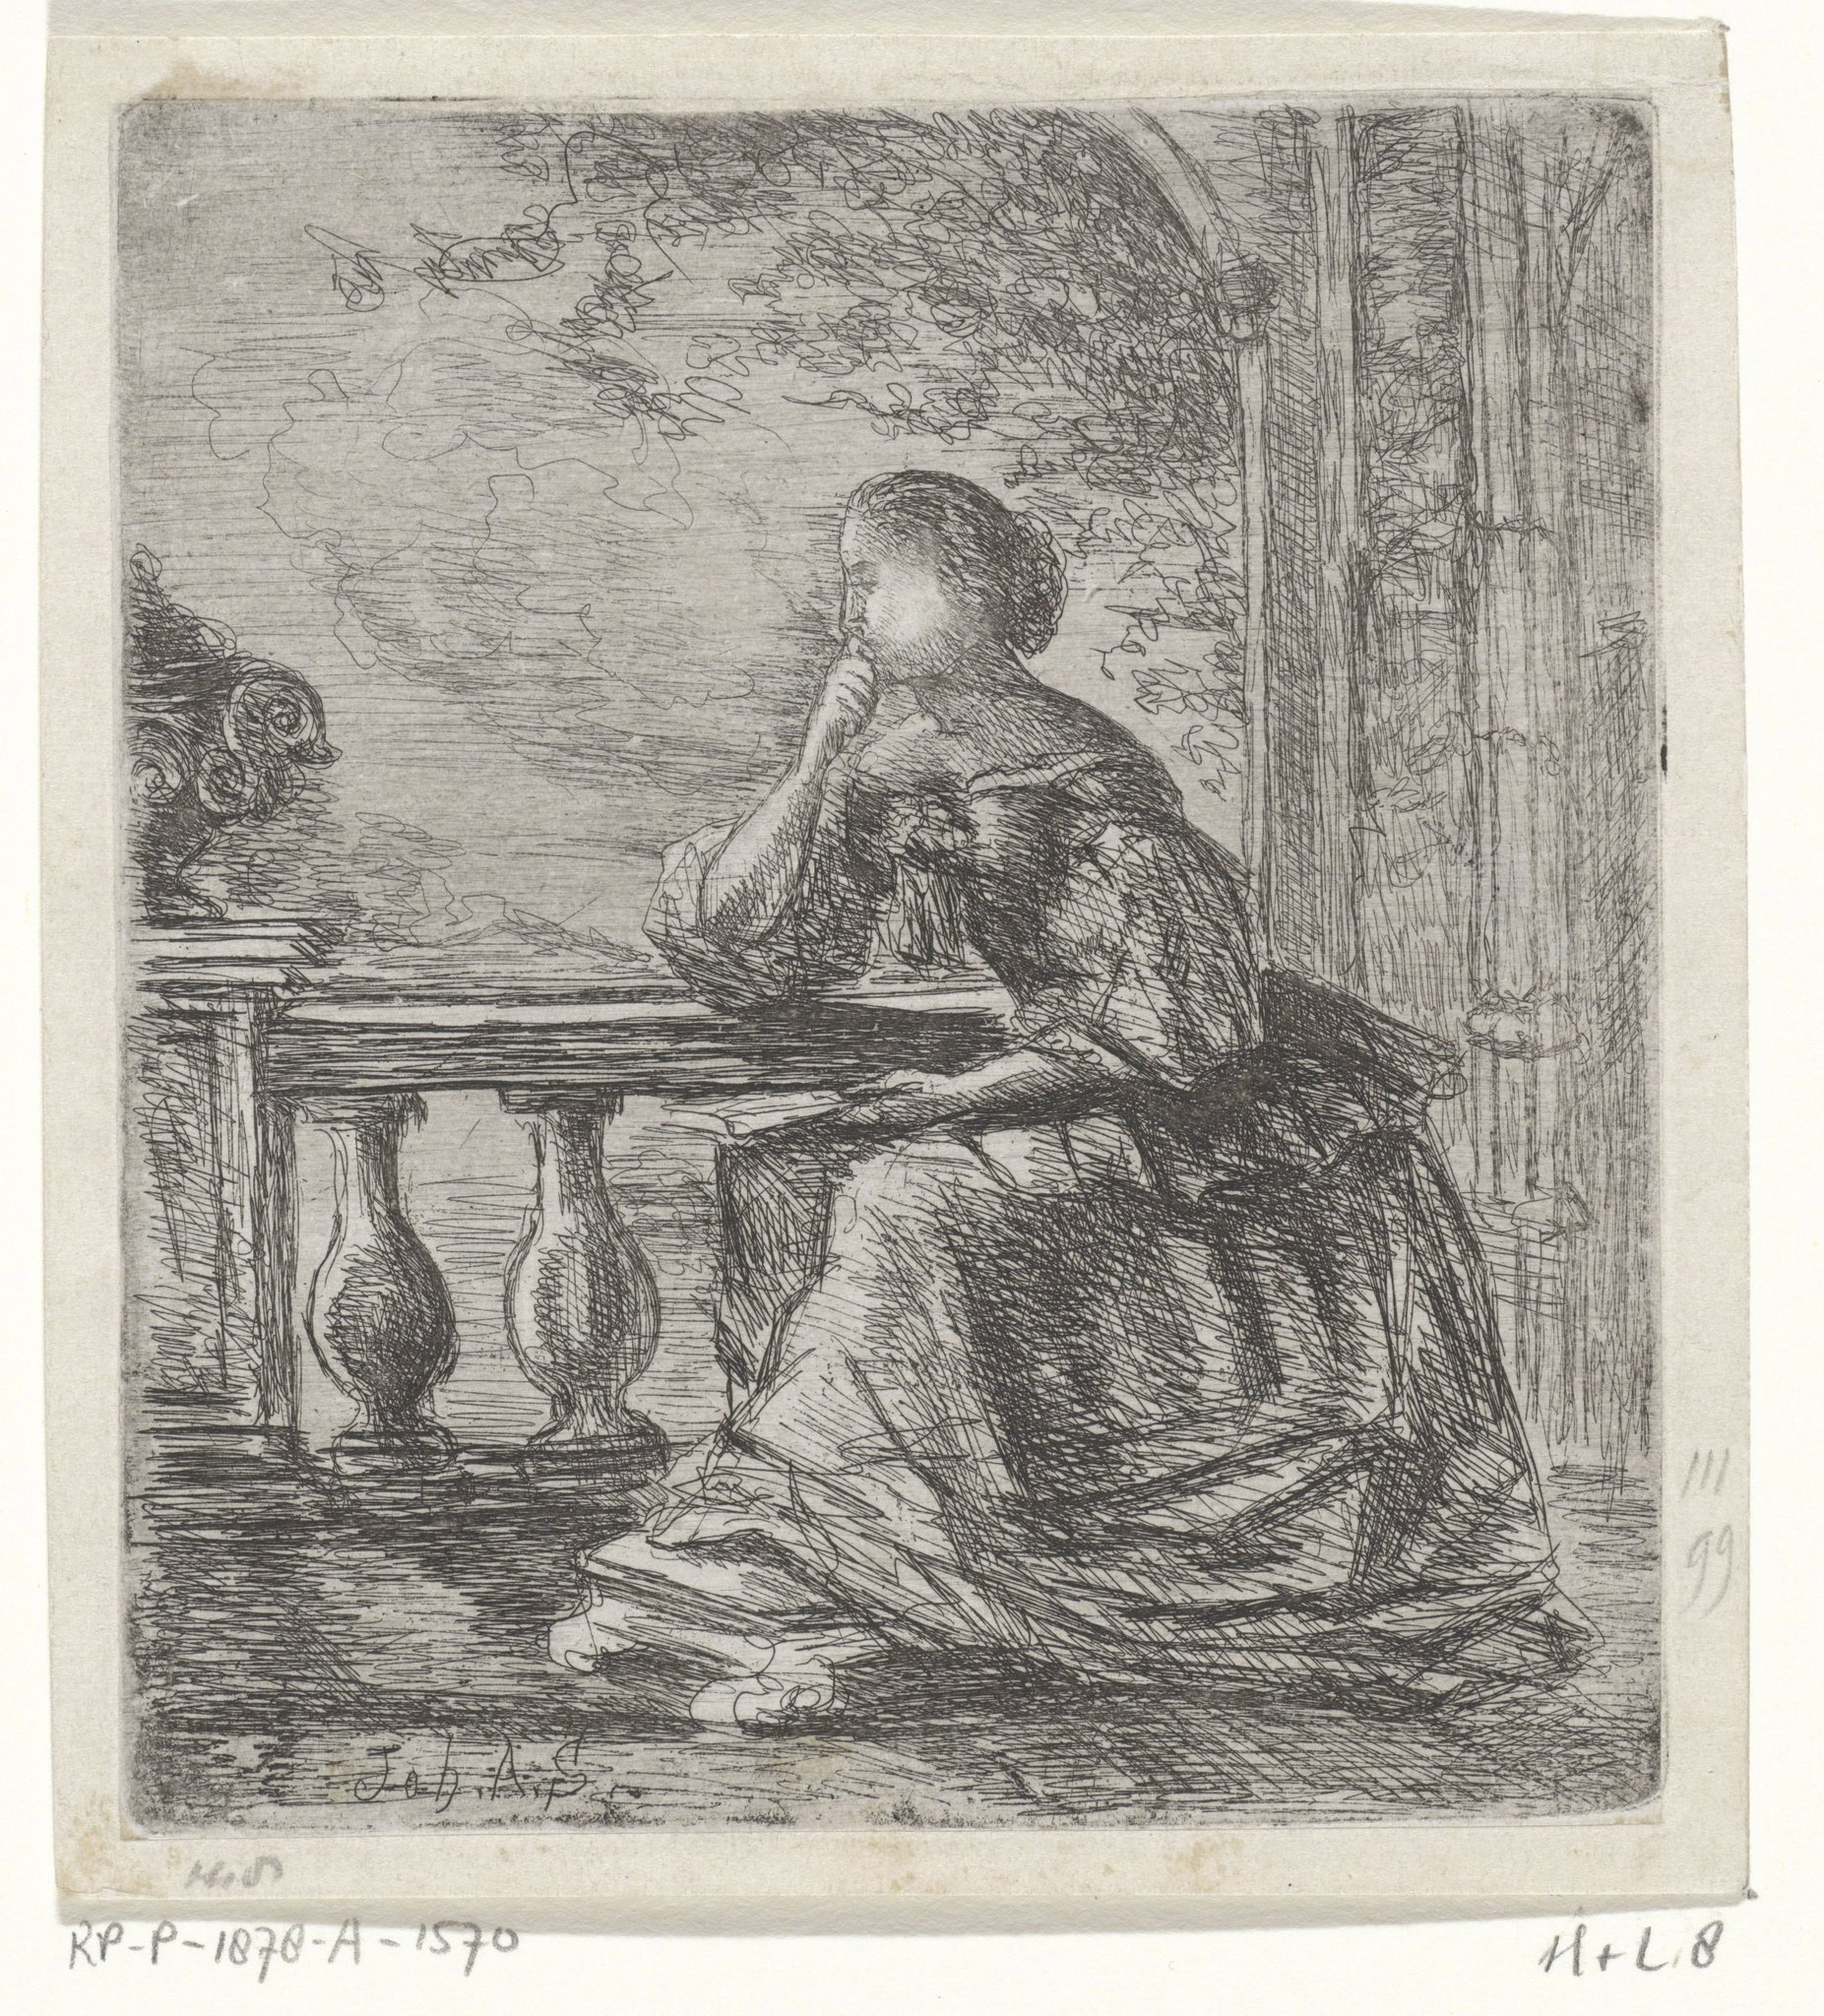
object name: print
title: Vrouw met een brief in de hand bij een balustrade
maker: johannes adrianus schultz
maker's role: print maker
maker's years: 1820-1863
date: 1830-1863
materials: paper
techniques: etching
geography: netherlands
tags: balustrade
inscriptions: collector's mark: Lugt 2228